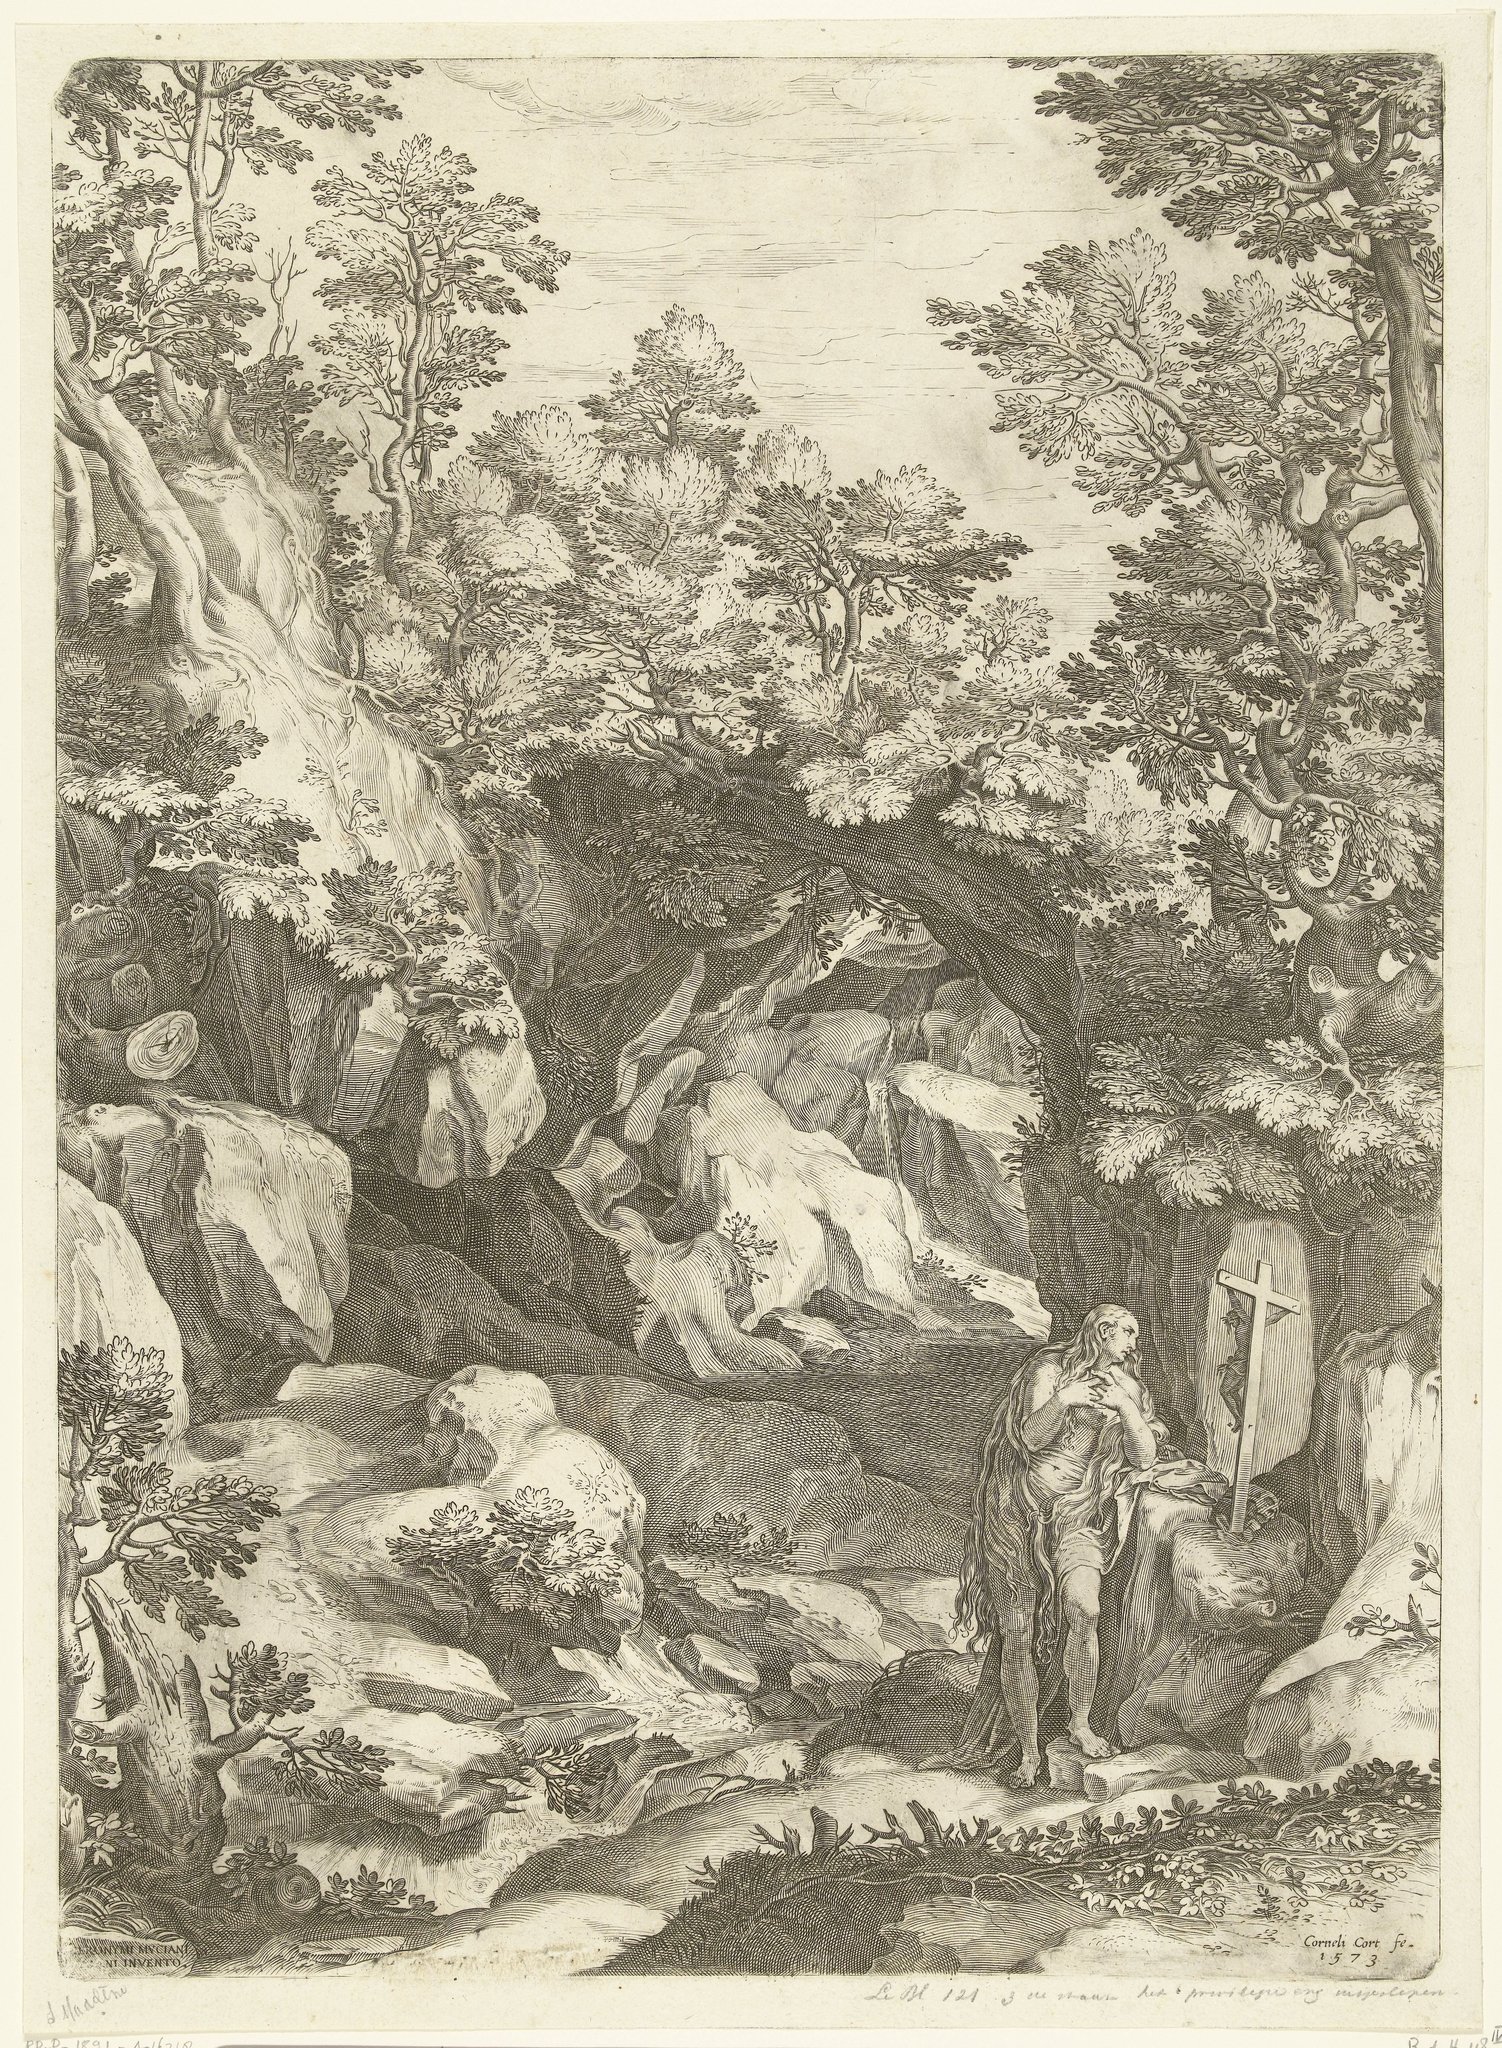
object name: print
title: Landschap met de boetvaardige Magdalena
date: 1573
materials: paper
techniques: engraving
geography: rome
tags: female saints (with name)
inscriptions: collector's mark: Lugt 2228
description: Landschap met de heilige Maria Magdalena biddend voor een crucifix in een ravijn.